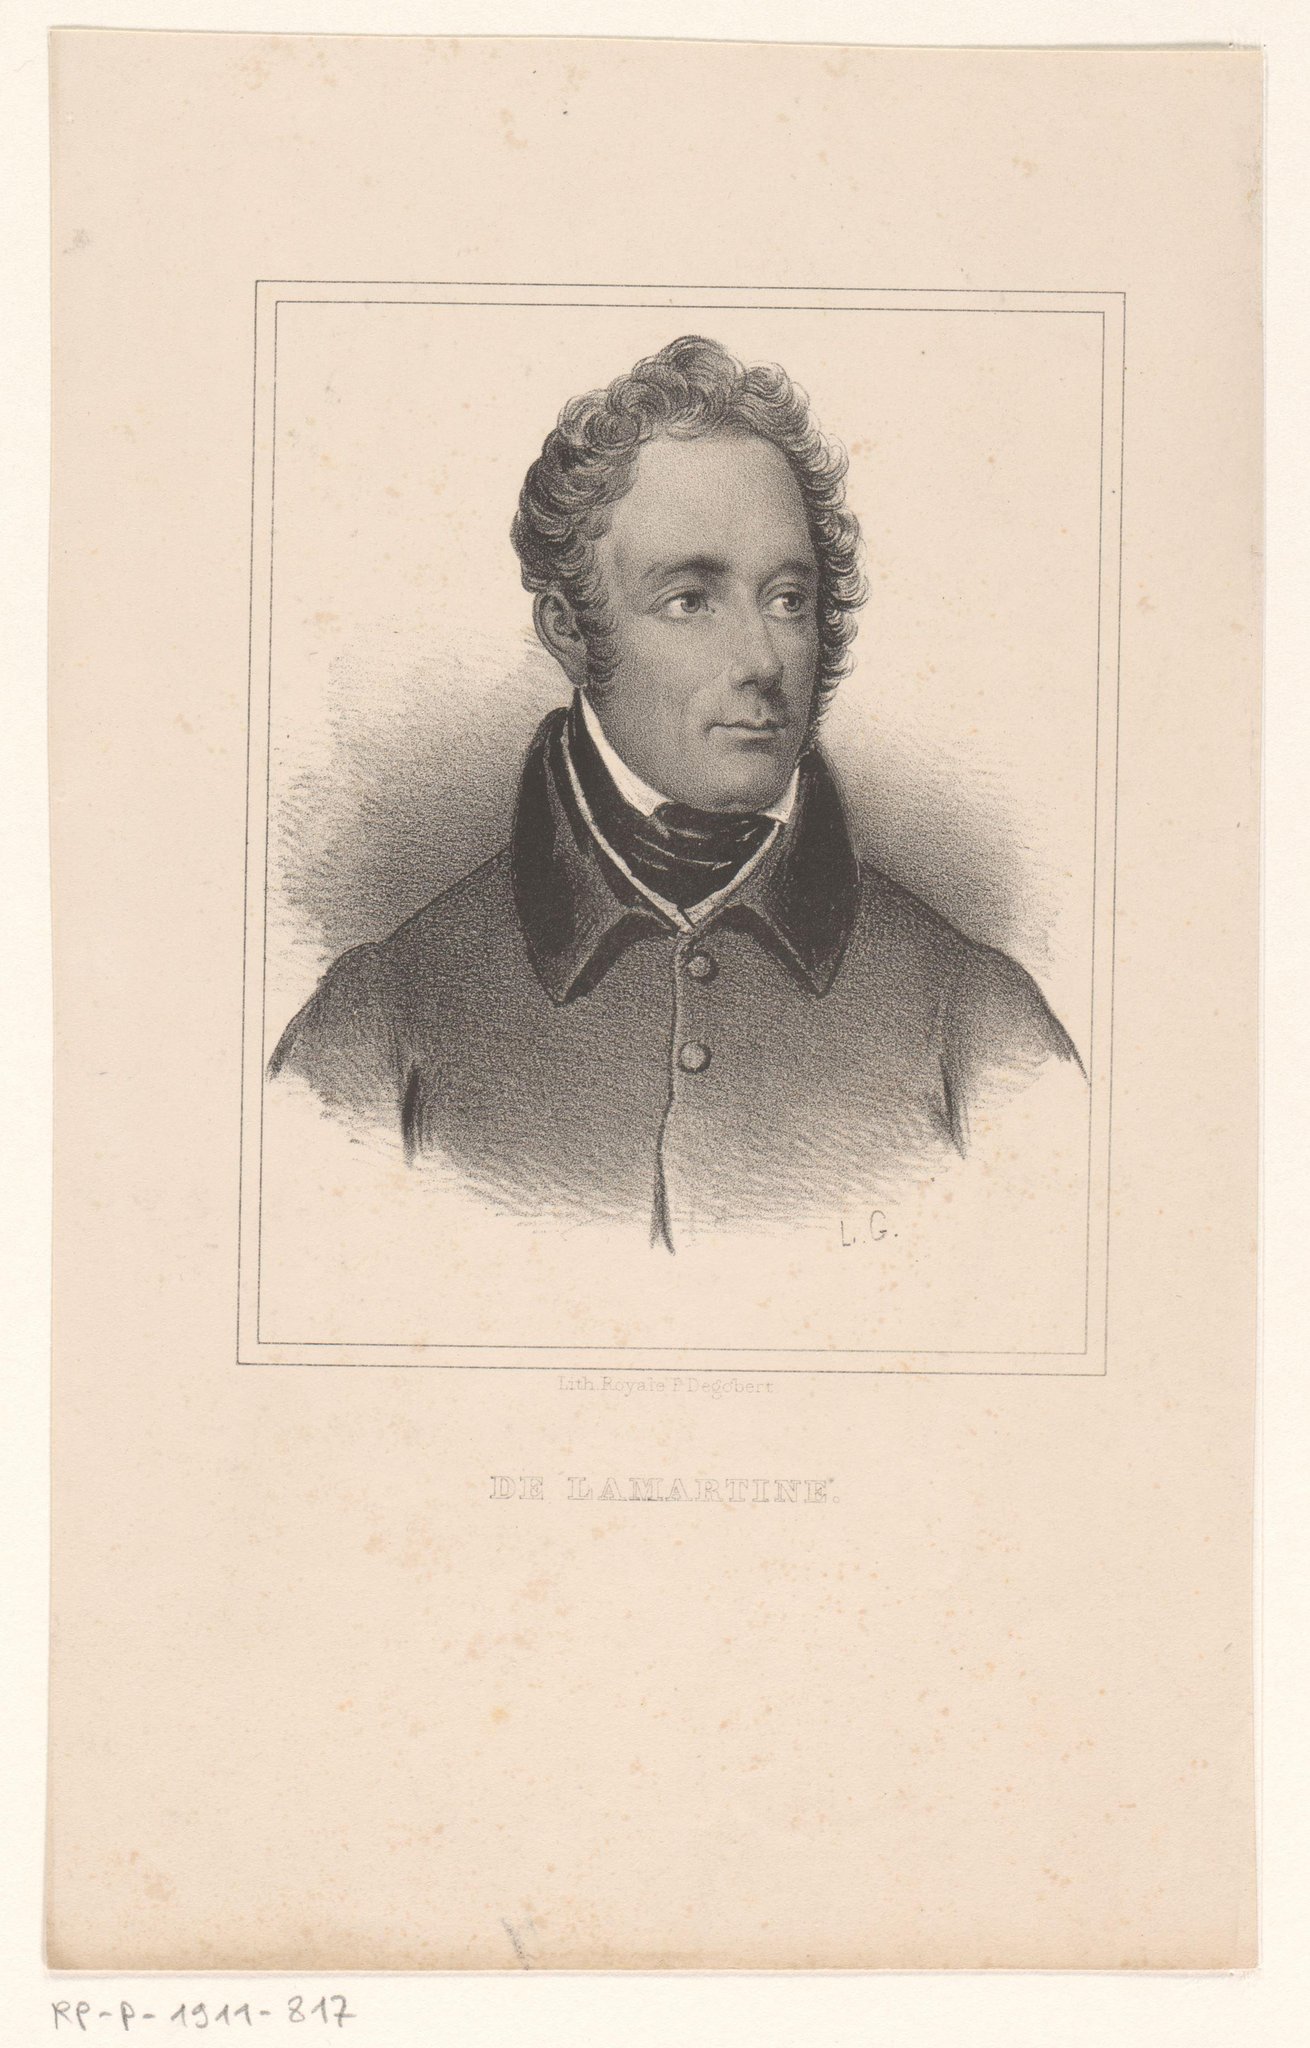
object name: print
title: Portret van Alphonse de Lamartine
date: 1830-1844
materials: paper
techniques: lithograph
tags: paris, minister ~ government, historical persons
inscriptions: collector's mark: Lugt 2228